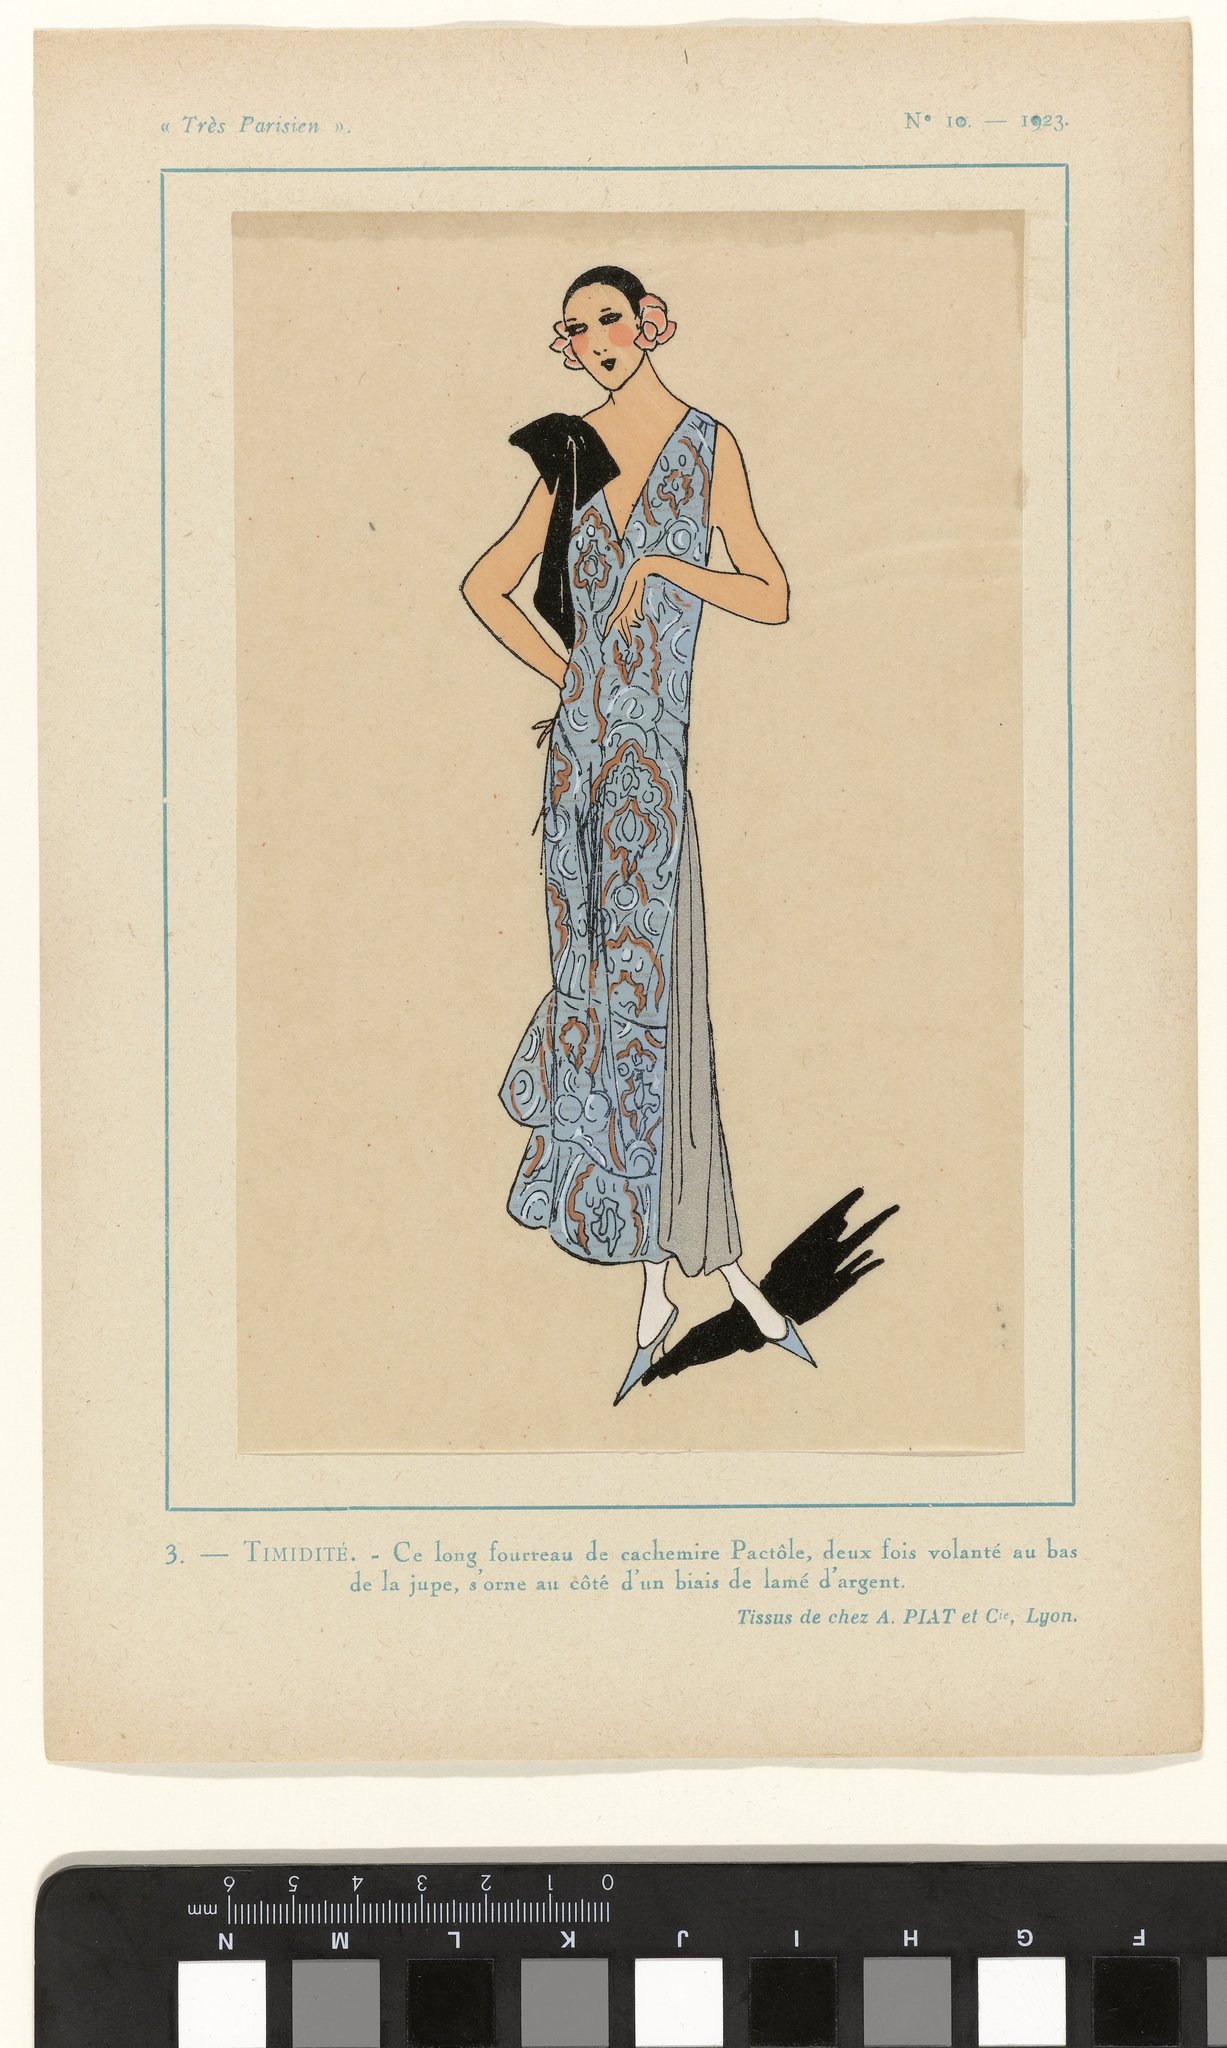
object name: fashion print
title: Très Parisien, 1923, No 10: 3.- TIMIDITÉ. - Ce long fourreau...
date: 1923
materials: paper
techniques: hand coloring, letterpress printing, lithography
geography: paris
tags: dress, gown (fourreau) (+ women's clothes), fashion plates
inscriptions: title: ‘Très Parisien / No 10. - 1923’, caption: ‘3. - TIMIDITÉ. - Ce long fourreau de cachemire Pactôle, deux fois volanté au bas de la jupe, s'orne au côté d'un biais de lamé d'argent. / Tissus de chez A. PIAT et Cie, Lyon.’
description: Fourreau van 'cachemire Pactôle' (kasjmier) met twee volants aan de onderkant van de rok en aan één zijde versierd met biaisband van zilverlamé. Stoffen van A. Piat et Cie. Prent uit het modetijdschrift Très Parisien (1920-1936).